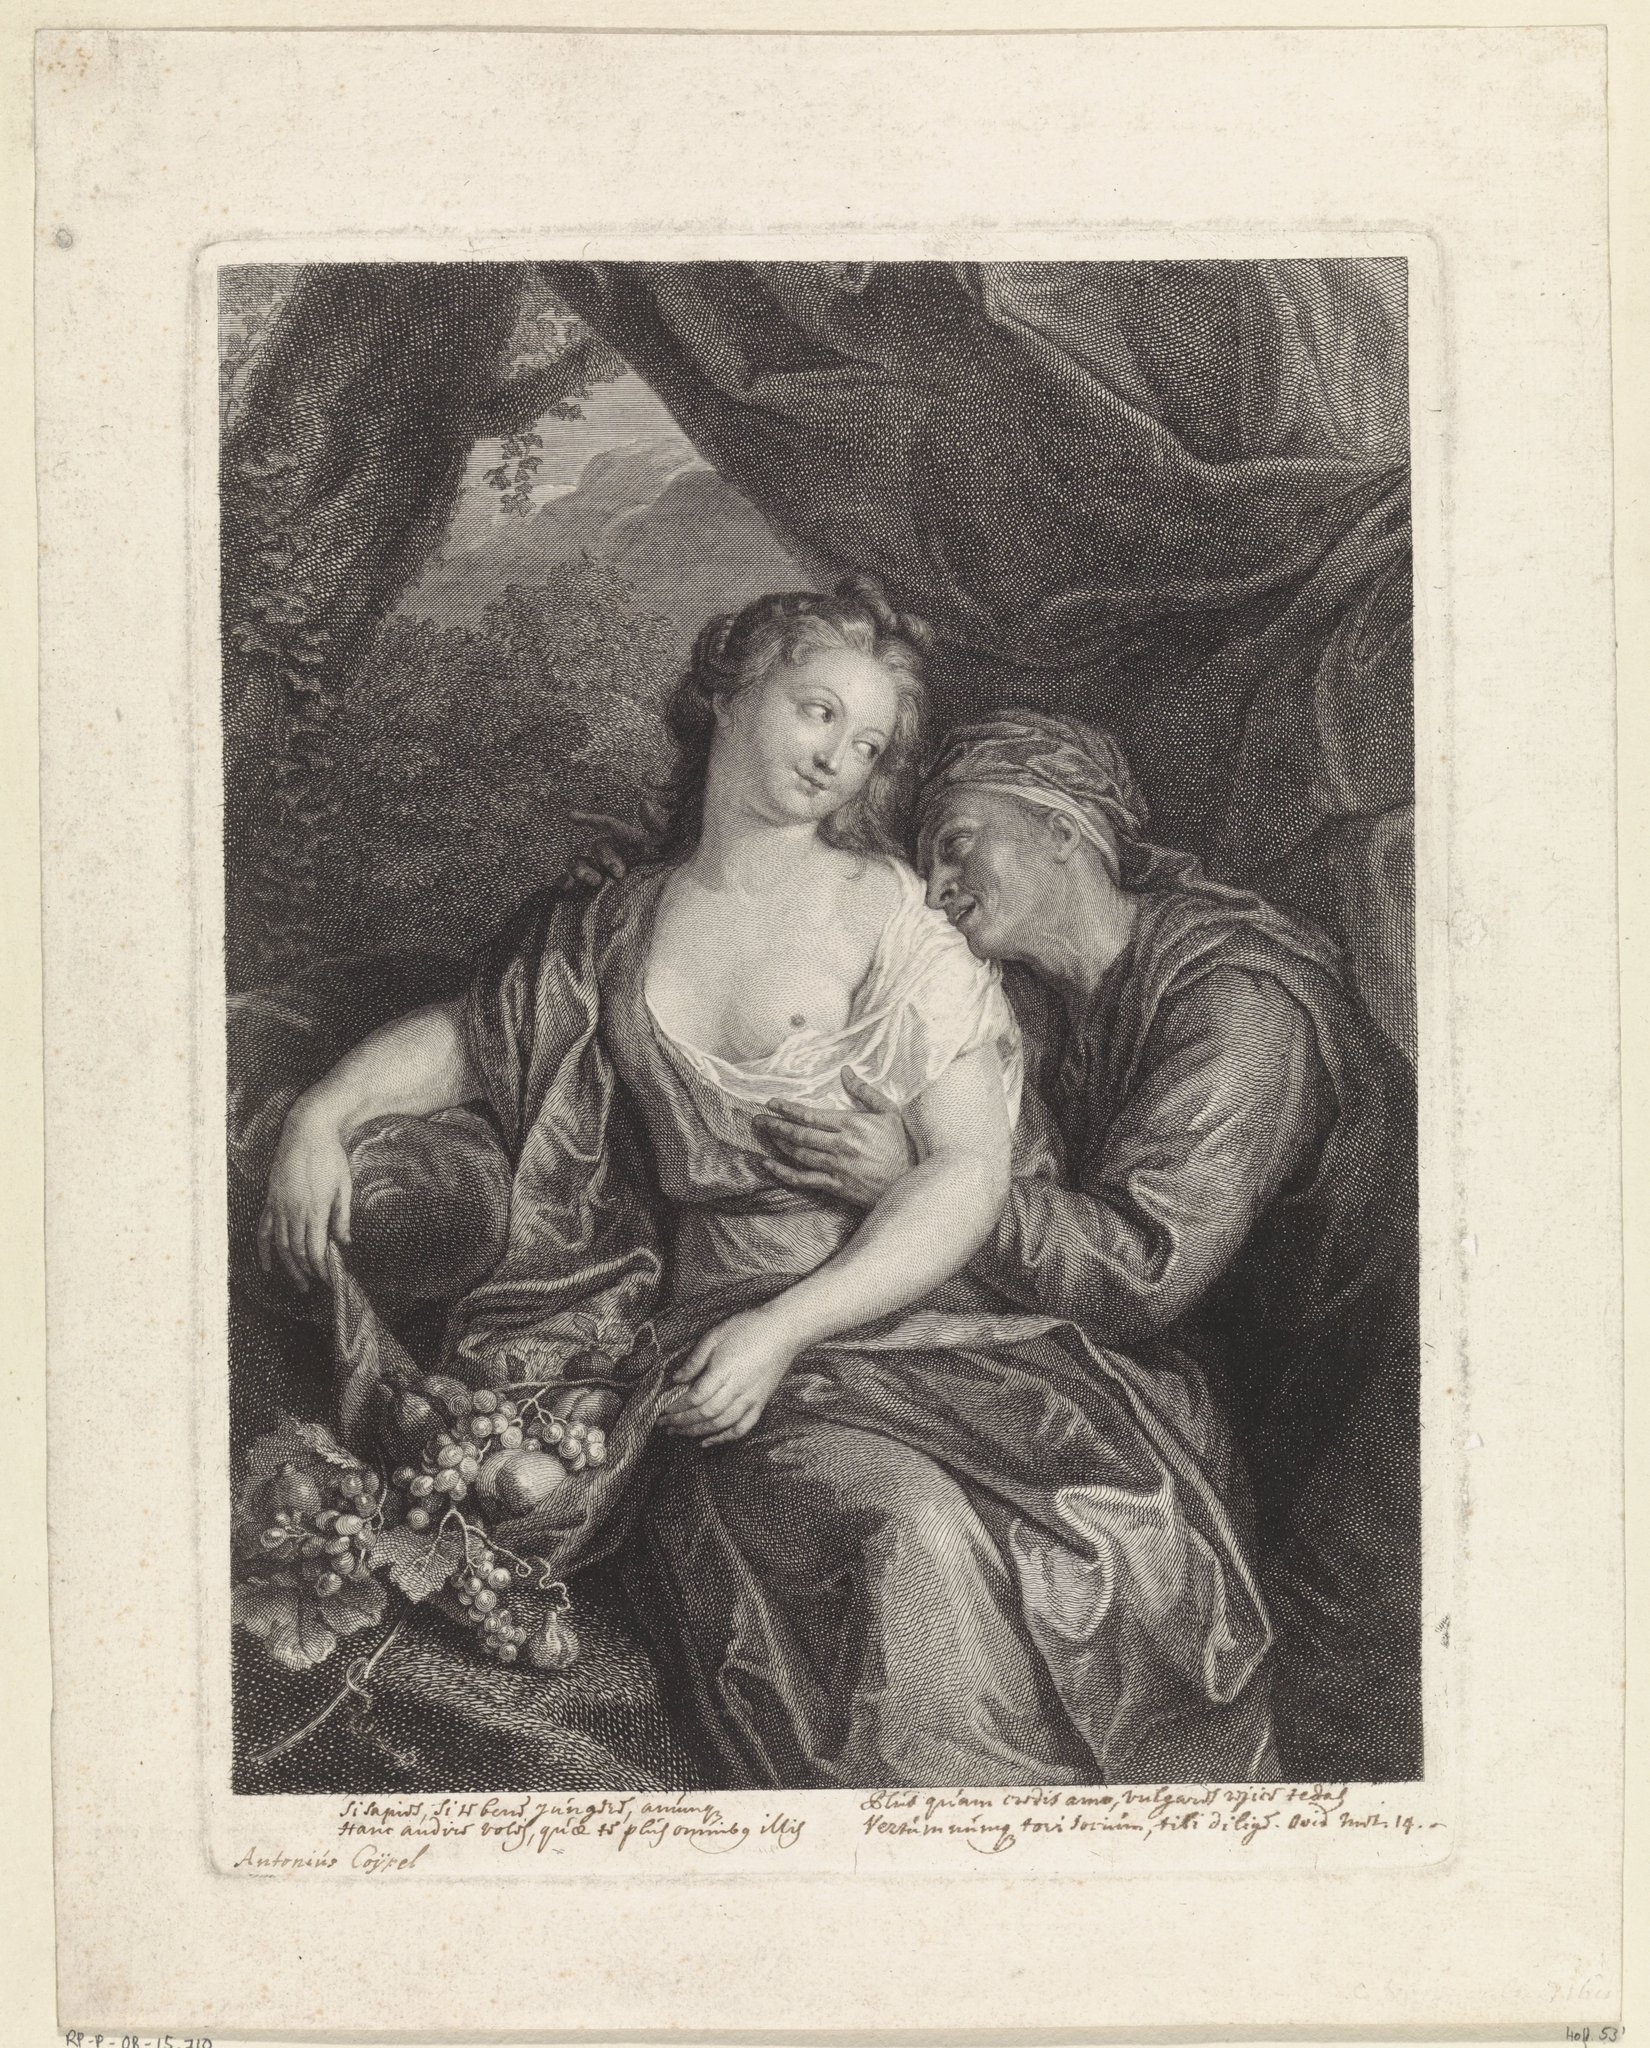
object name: print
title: Vertumnus en Pomona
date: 1654-1709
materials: paper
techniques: engraving, etching, pen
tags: vertumnus and pomona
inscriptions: collector's mark: Lugt 240